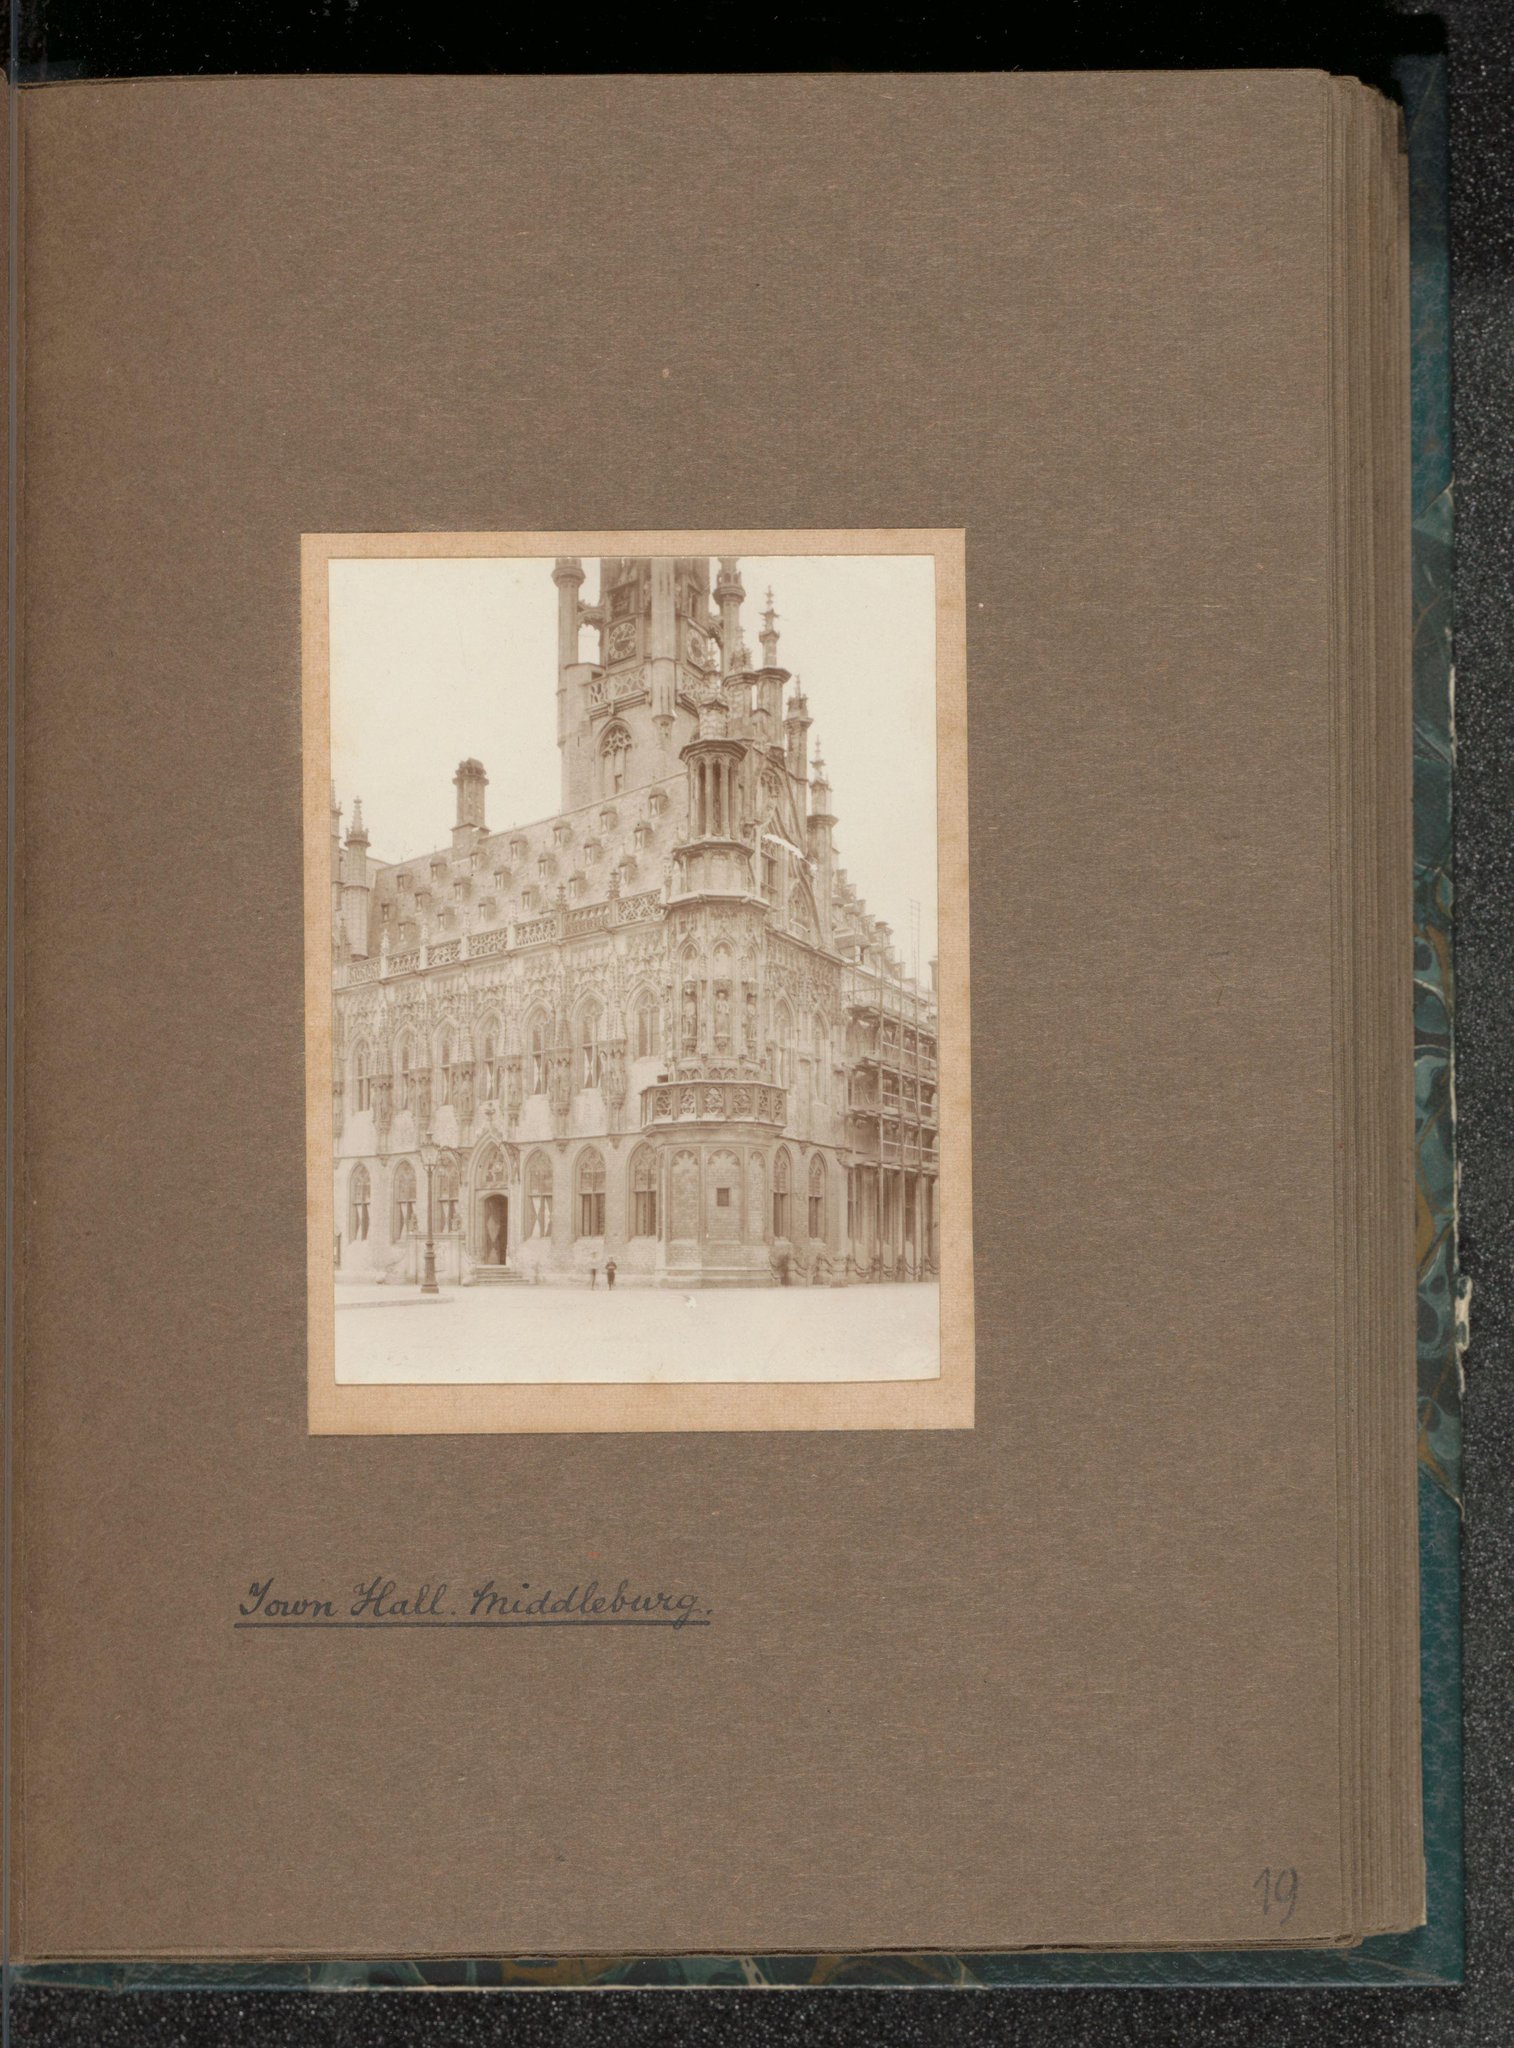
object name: photograph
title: Town Hall Middleburg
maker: Anonymous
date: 1912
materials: photographic support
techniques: gelatin silver print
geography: middelburg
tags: tower, clock tower ~ monumental adornment, townhall, travelling; tourism, middelburg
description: Onderdeel van Fotoalbum van de excursie naar Nederland van de Britse amateurfotografenvereniging P.C.U.K.